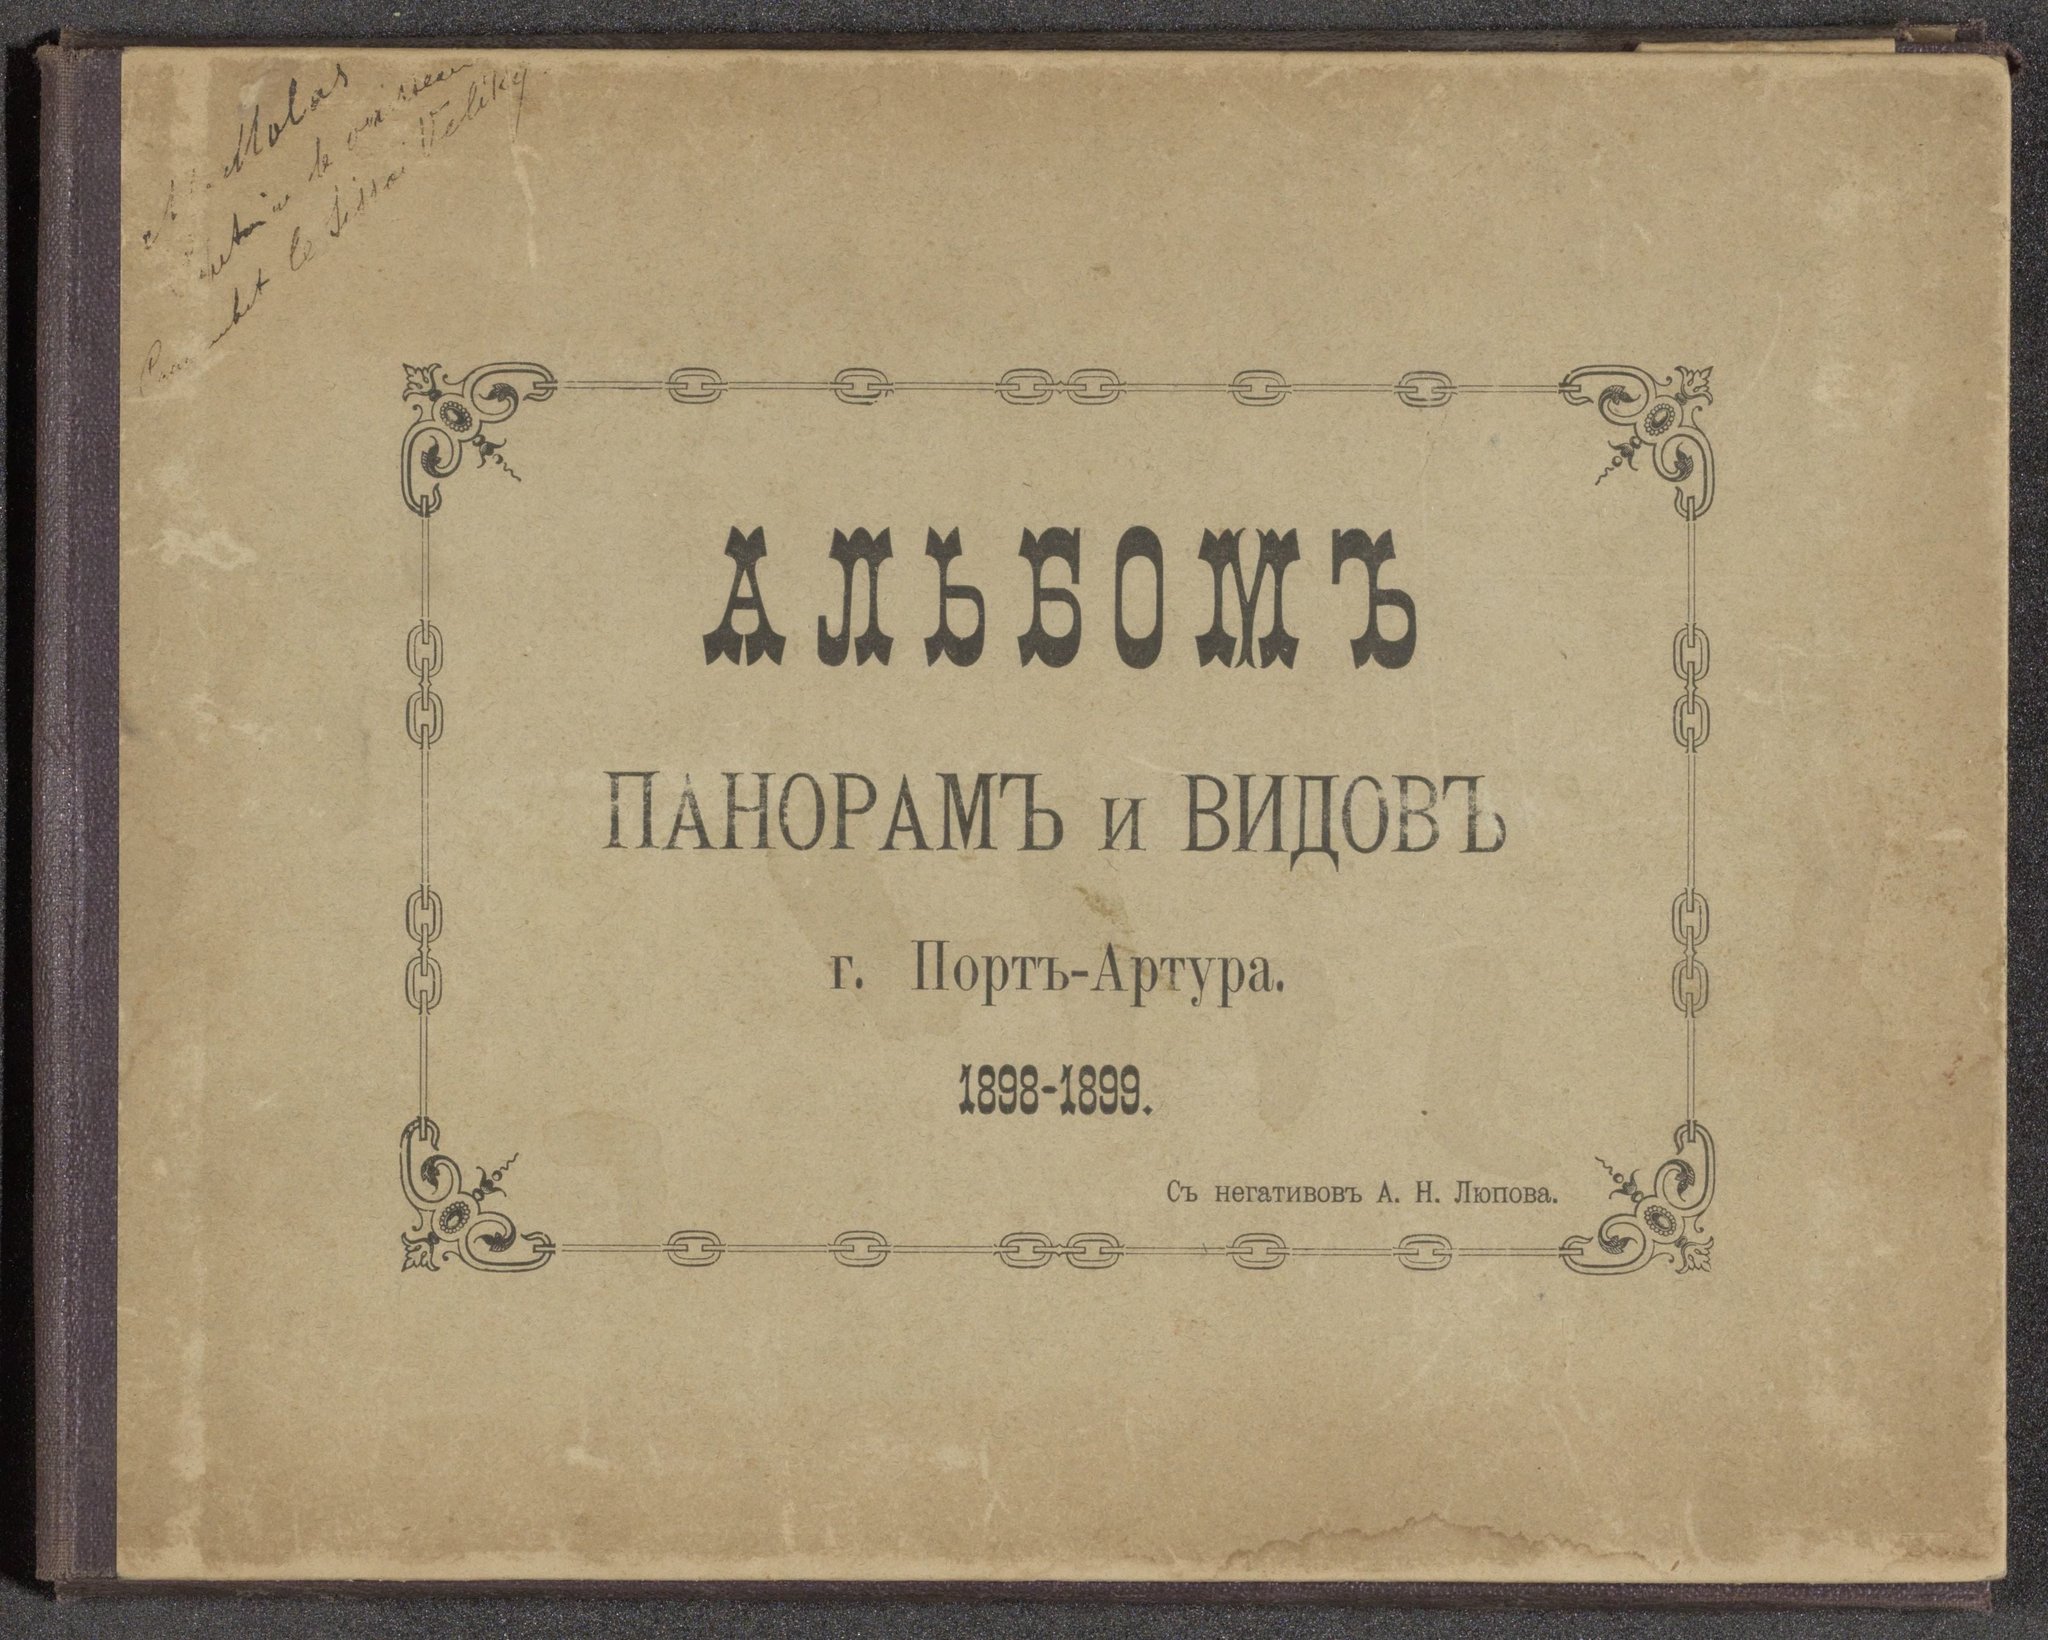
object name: page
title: Alb'om' panoram' i vidov g. Port'-Artura 1898-1899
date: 1900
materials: cardboard, linen, paper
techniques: photograph, printing, writing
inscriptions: inscription: ‘M. Molas [...] le Sissoi Velicky.’